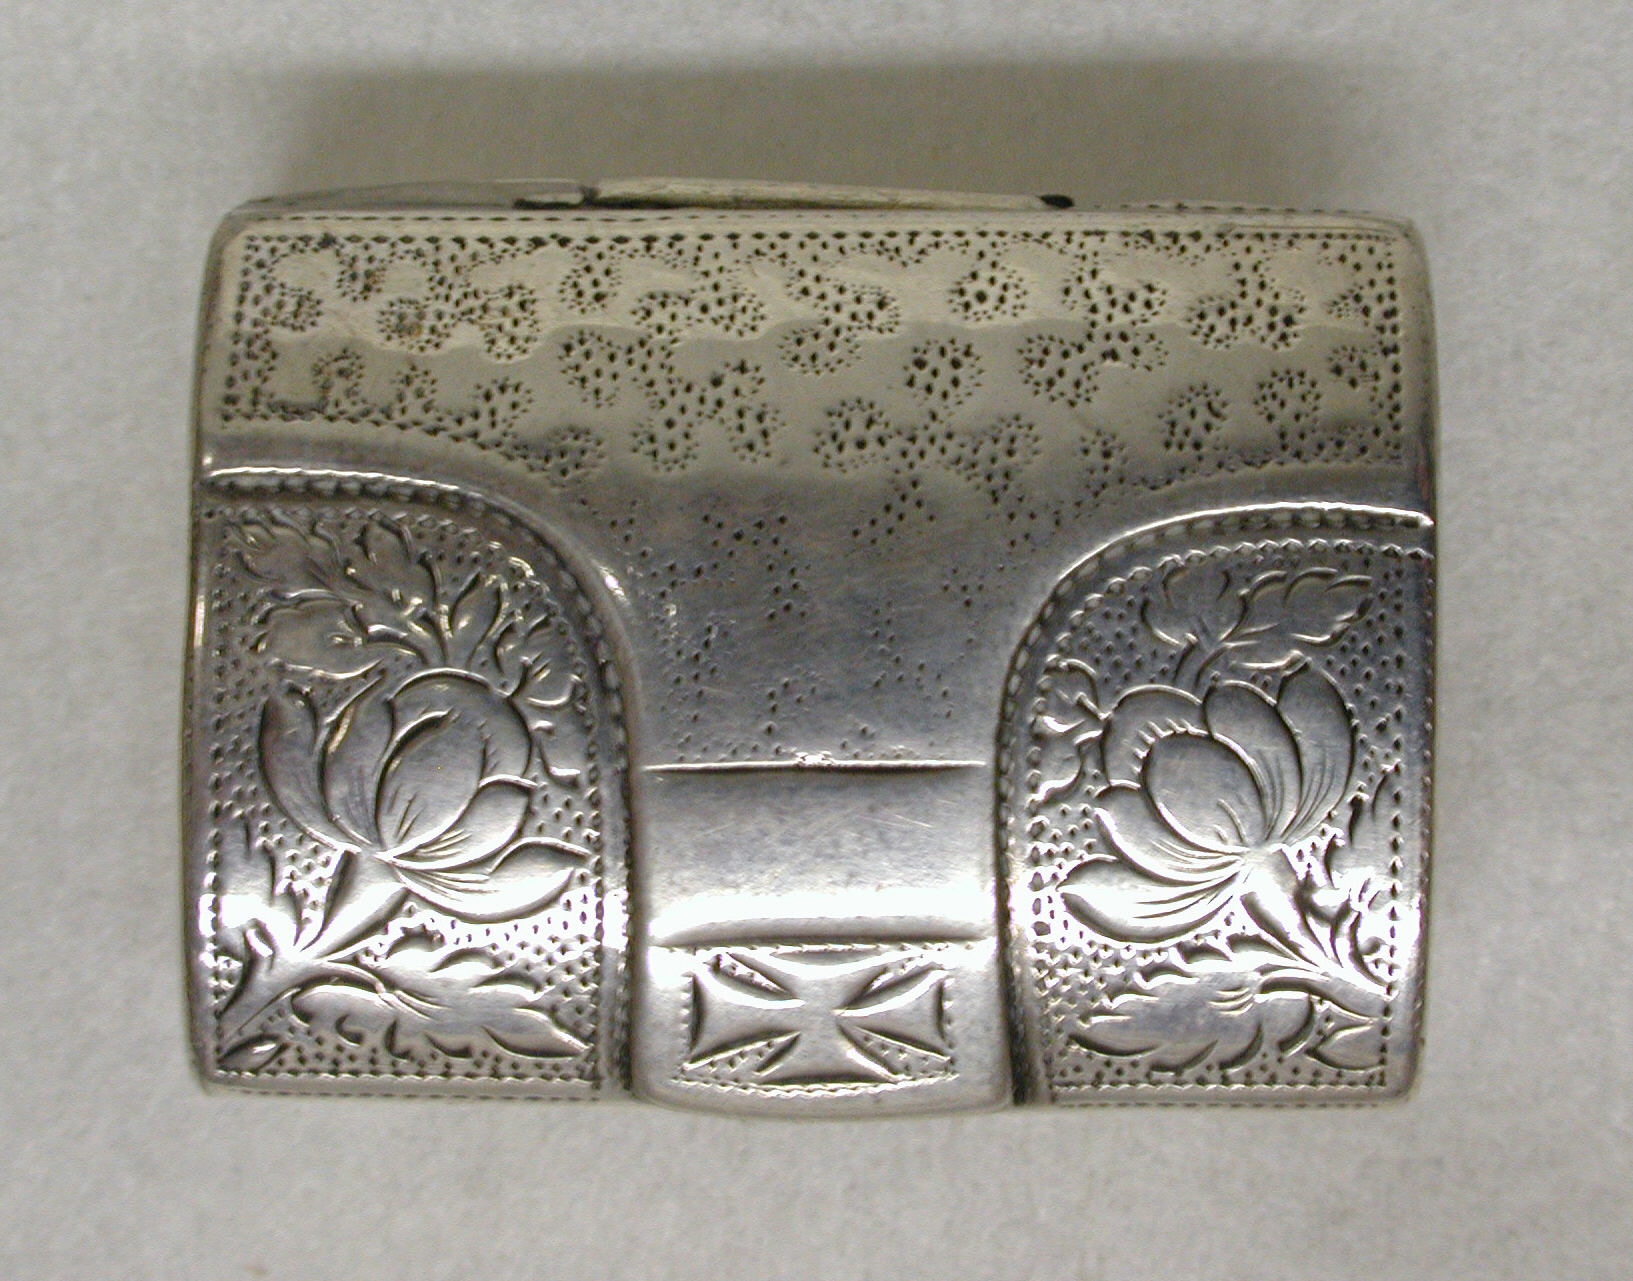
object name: vinaigrette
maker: joseph taylor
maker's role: maker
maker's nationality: british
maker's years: 1767-1827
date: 1806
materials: silver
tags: lotuses,leaves